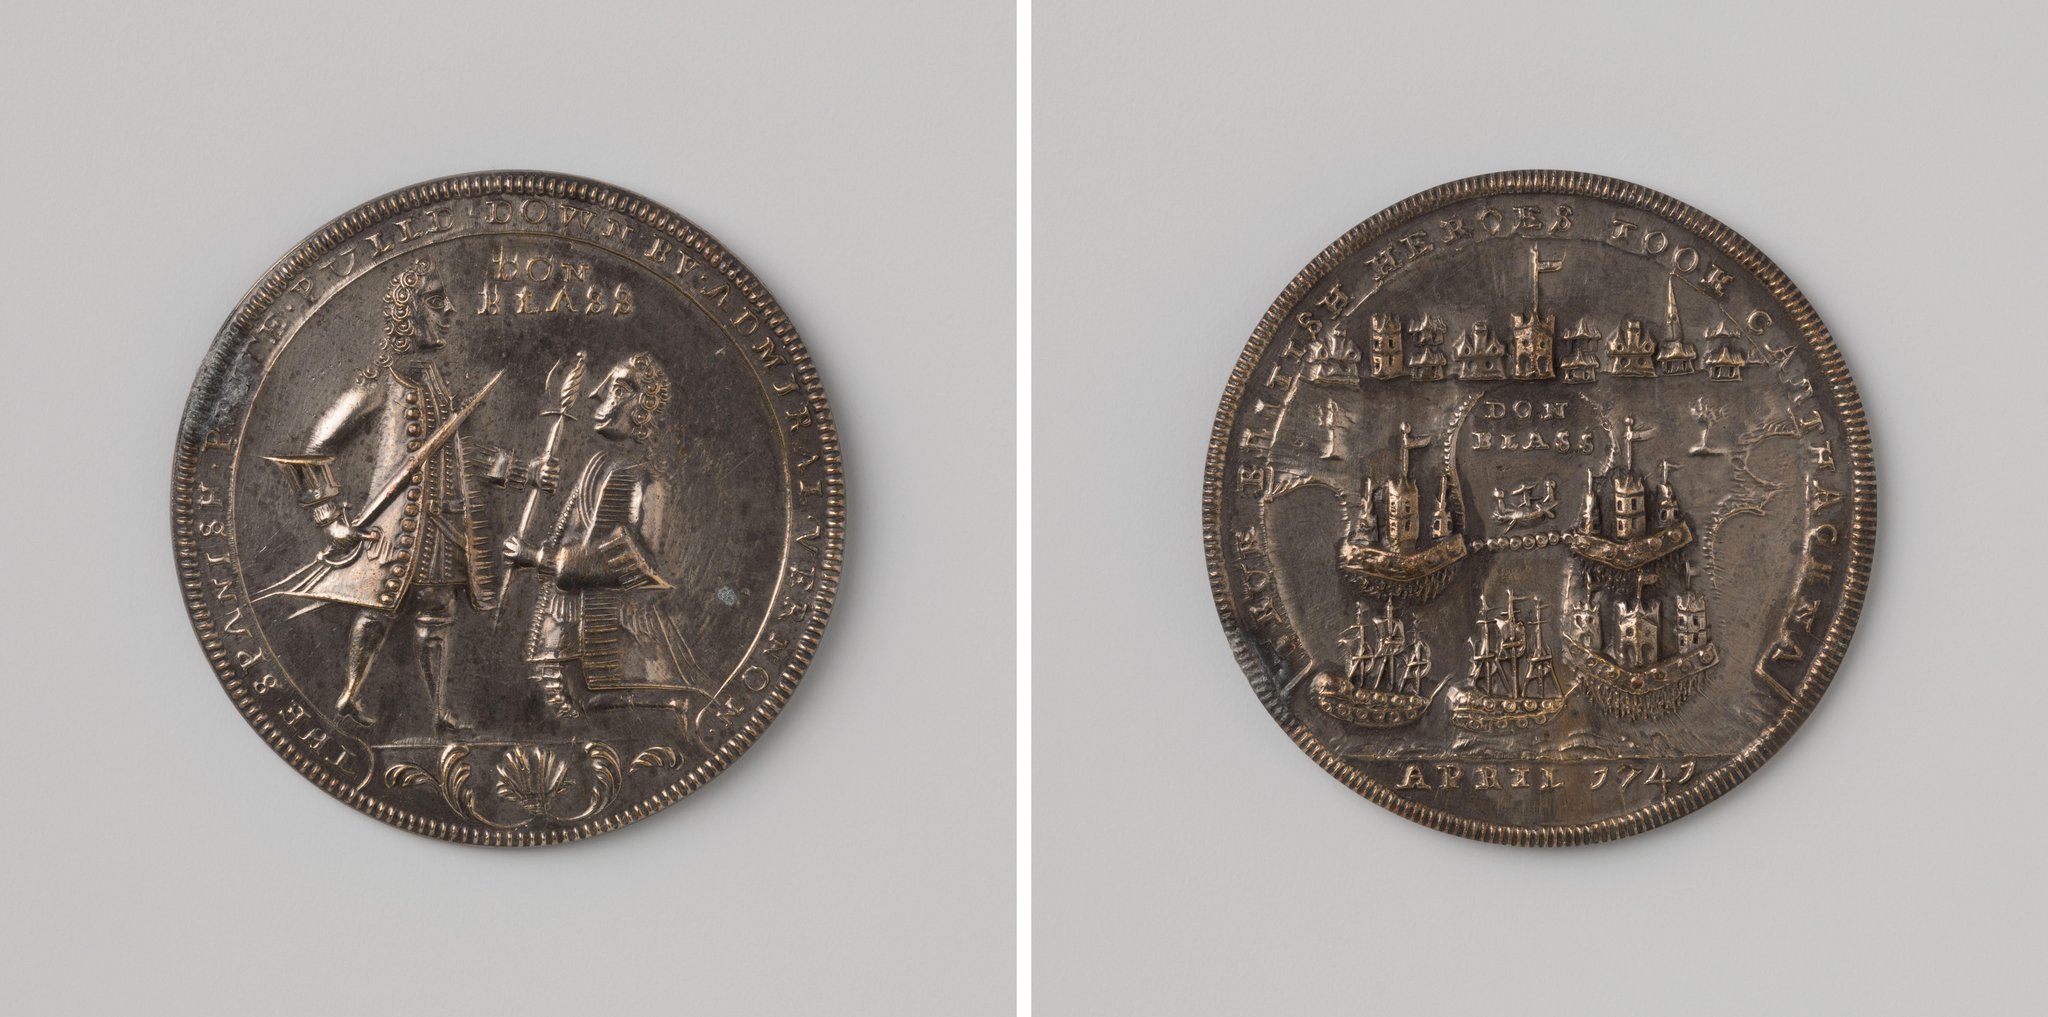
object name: history medal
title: Inname van Carthagena door admiraal Vernon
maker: edward pinchbeck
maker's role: medailleur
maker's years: 1713-1766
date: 1741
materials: alloy, metal alloy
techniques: striking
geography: england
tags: sir edward vernon, don blas de leso, colombia, cartagena, engels-spaanse oorlog, inname van carthagena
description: Penning. Voorzijde: Don Blas de Leso, commandant van de Spaanse troepen, knielt voor Vernon met zwaard en overhandigt hem zijn zwaard binnen omschrift. Keerzijde: schepen lopen haven van Carthagena binnen, die met een ketting afgesloten wordt binnen omschrift; afsnede: datum